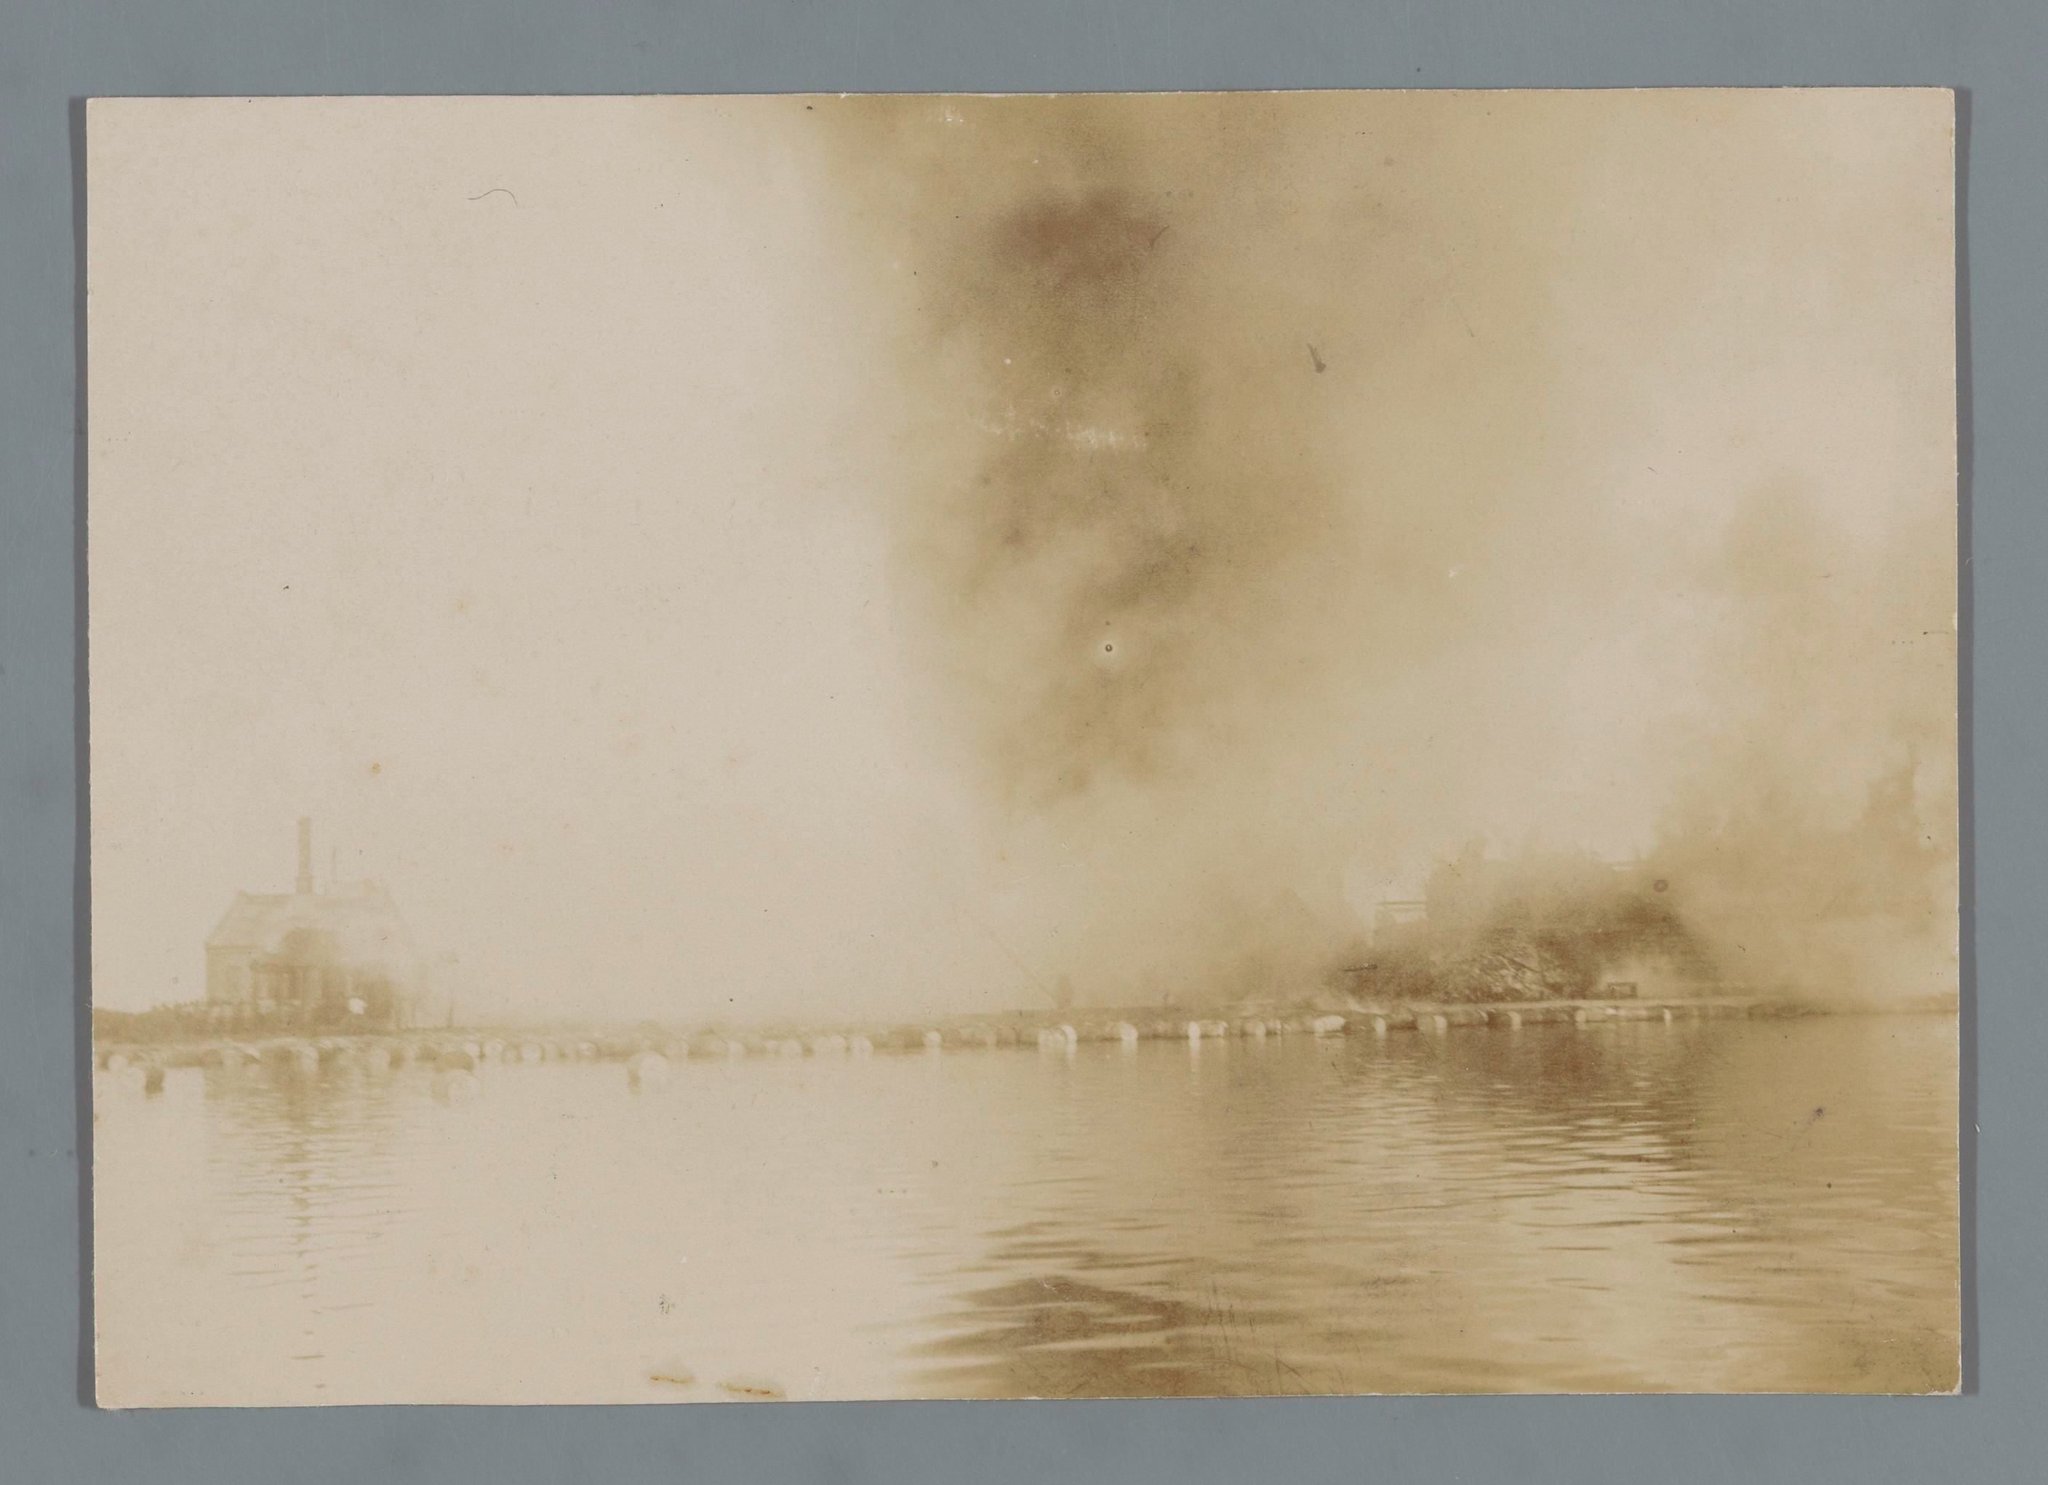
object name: photograph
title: Gezicht op een brand langs de waterkant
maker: Anonymous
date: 1904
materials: photographic support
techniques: gelatin silver print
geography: netherlands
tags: open fire (in general), landscapes with waters, waterscapes, seascapes (in the temperate zone), housing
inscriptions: inscription: ‘1904’